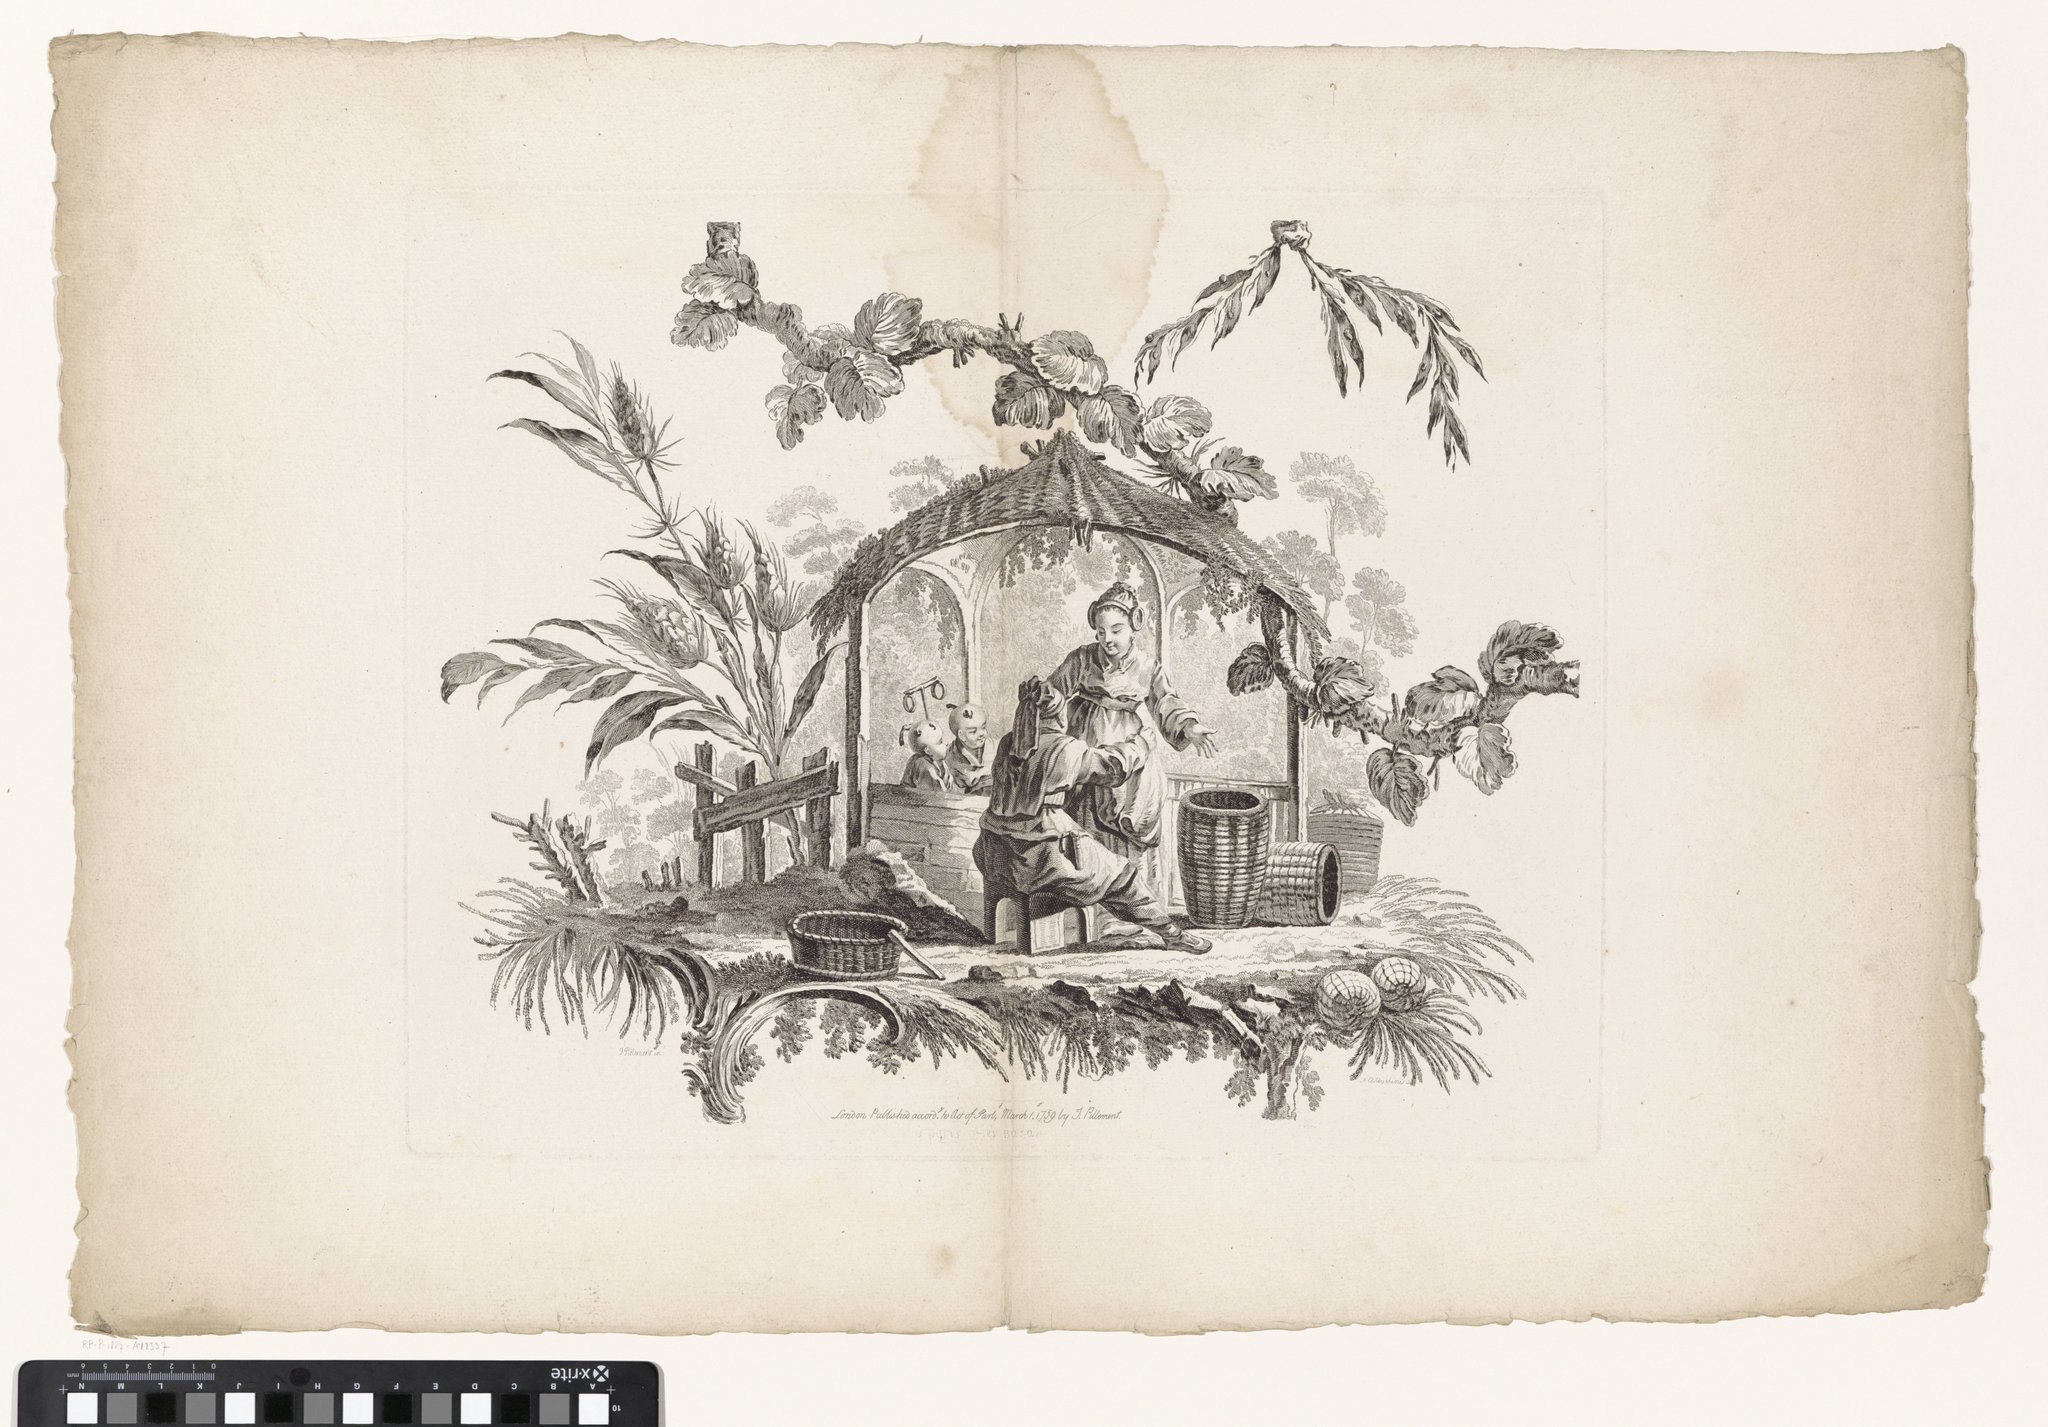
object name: print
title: Chinees gezin bij een prieel met begroeiing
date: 1759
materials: paper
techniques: engraving, etching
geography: london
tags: parents with their children, chinese, pastorals, arcadian scenes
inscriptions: collector's mark: Lugt 2228